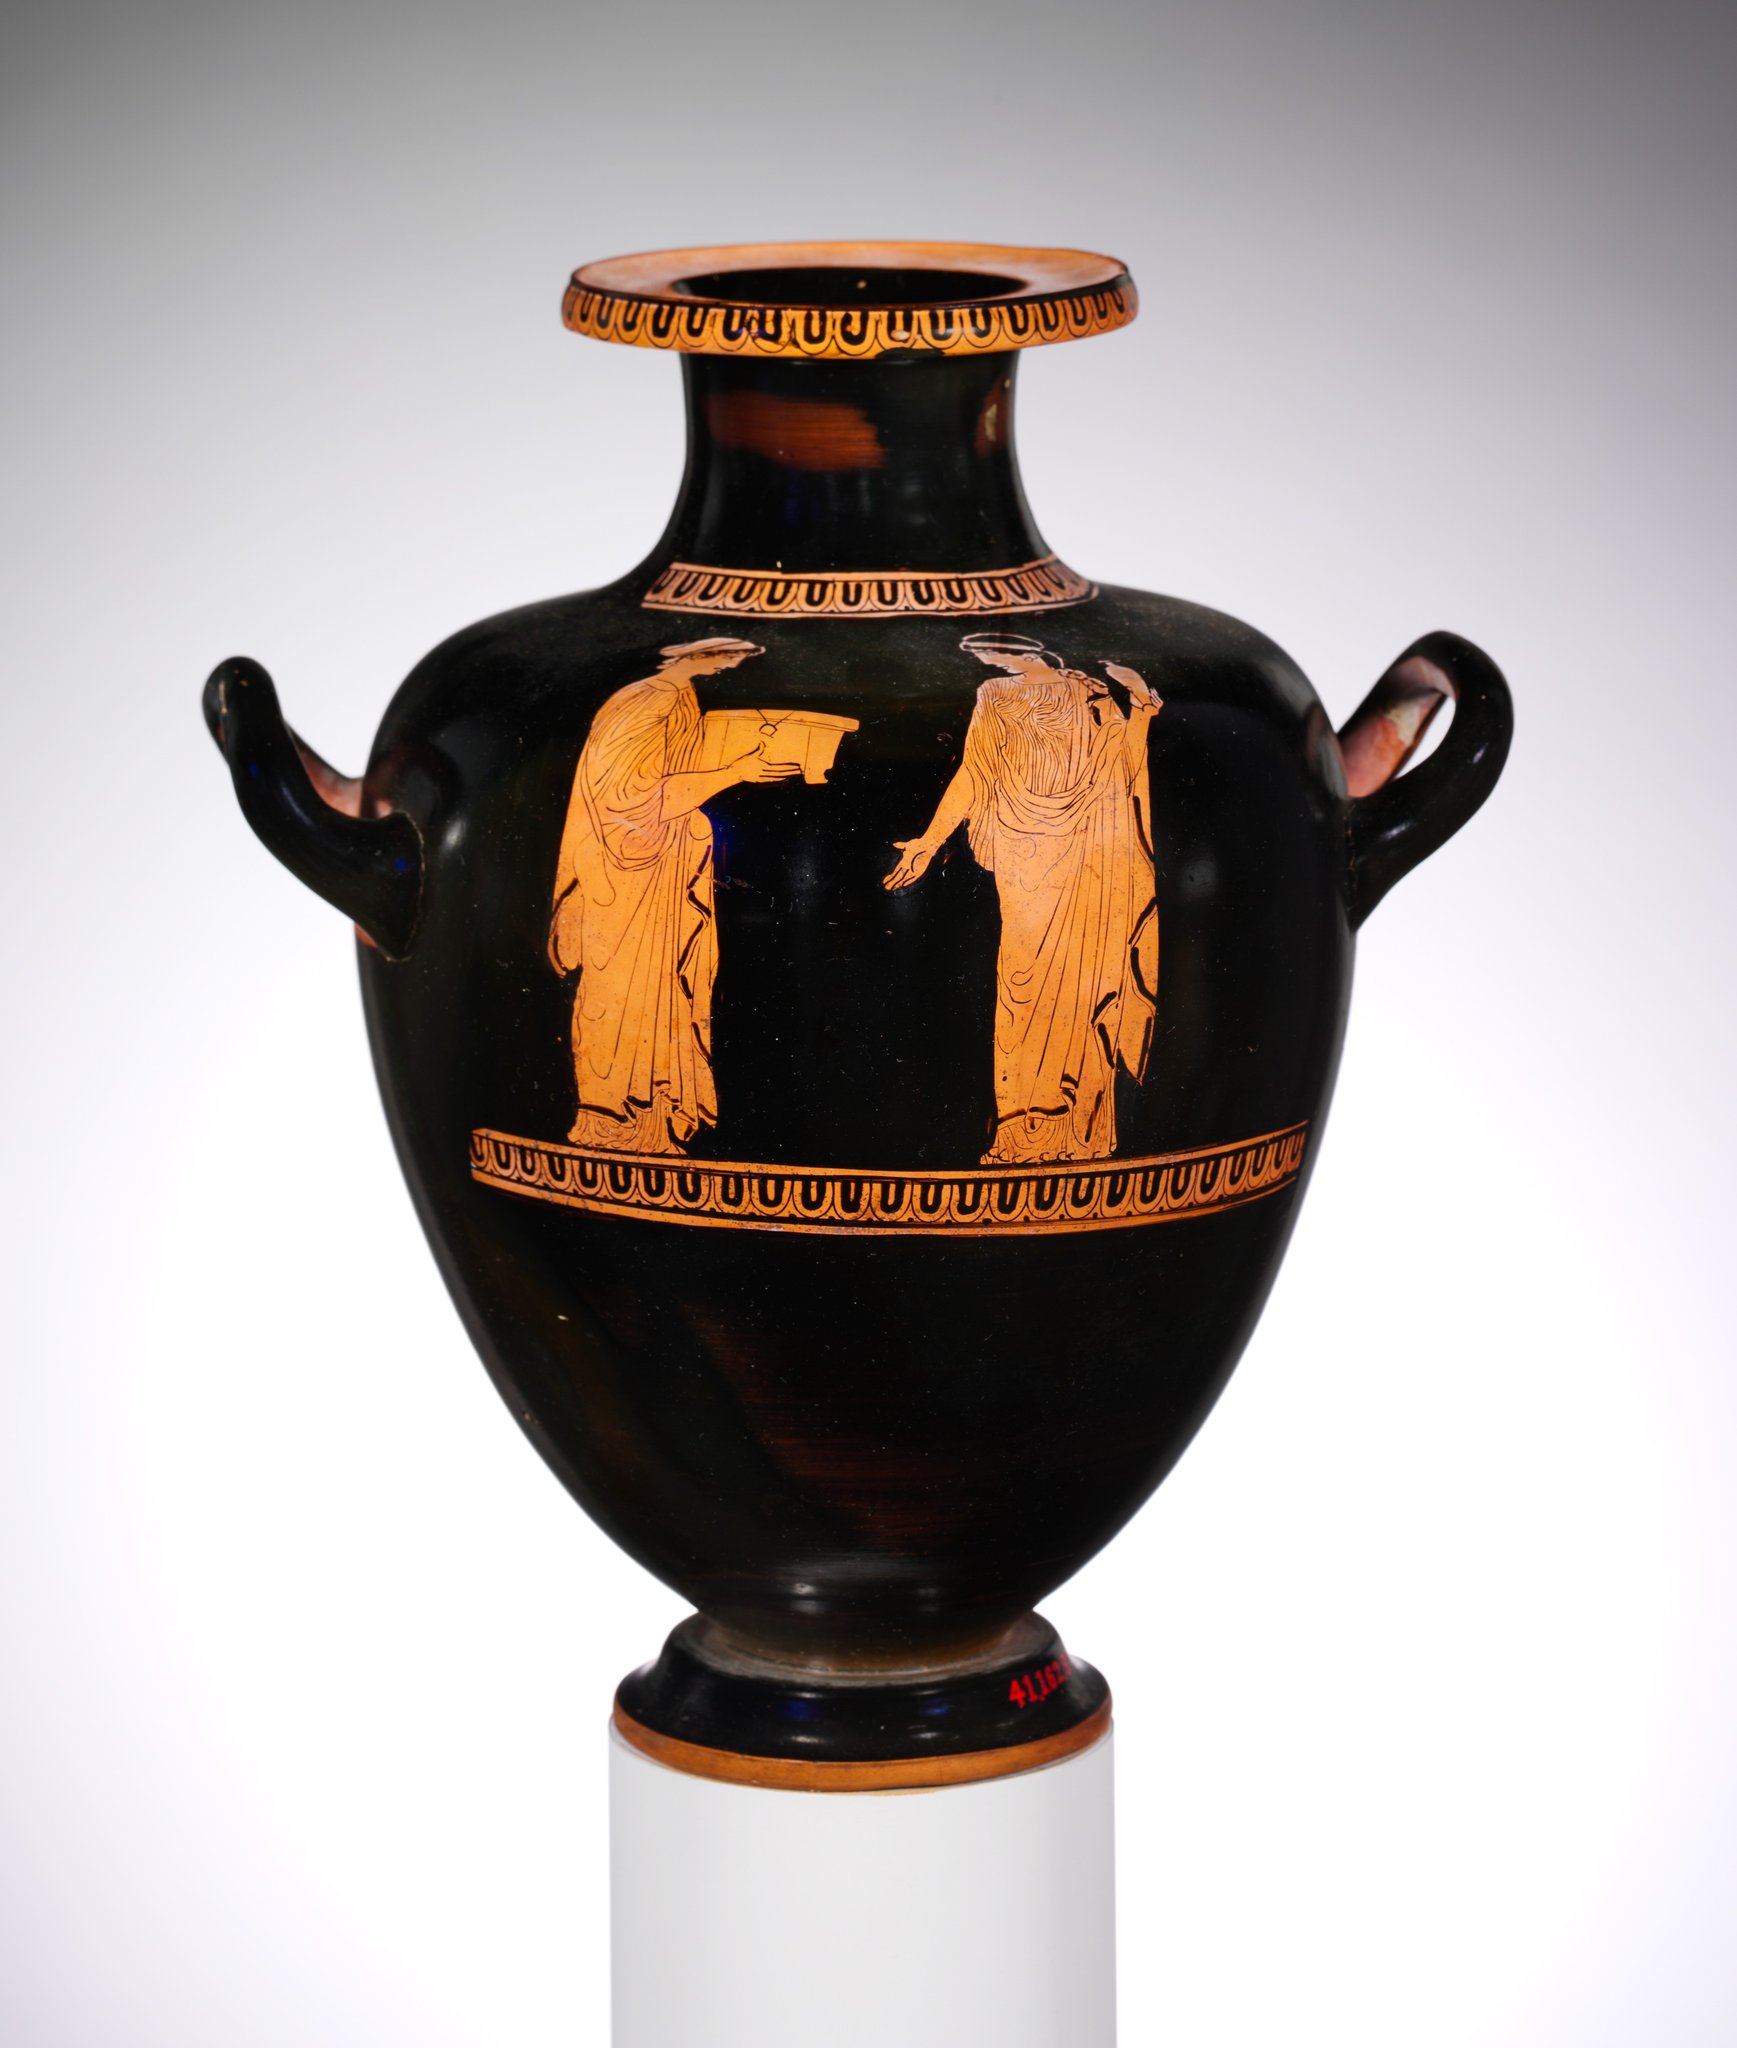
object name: hydria, kalpis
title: Terracotta hydria: kalpis (water jar)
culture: greek, attic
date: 434-401 BCE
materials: terracotta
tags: women